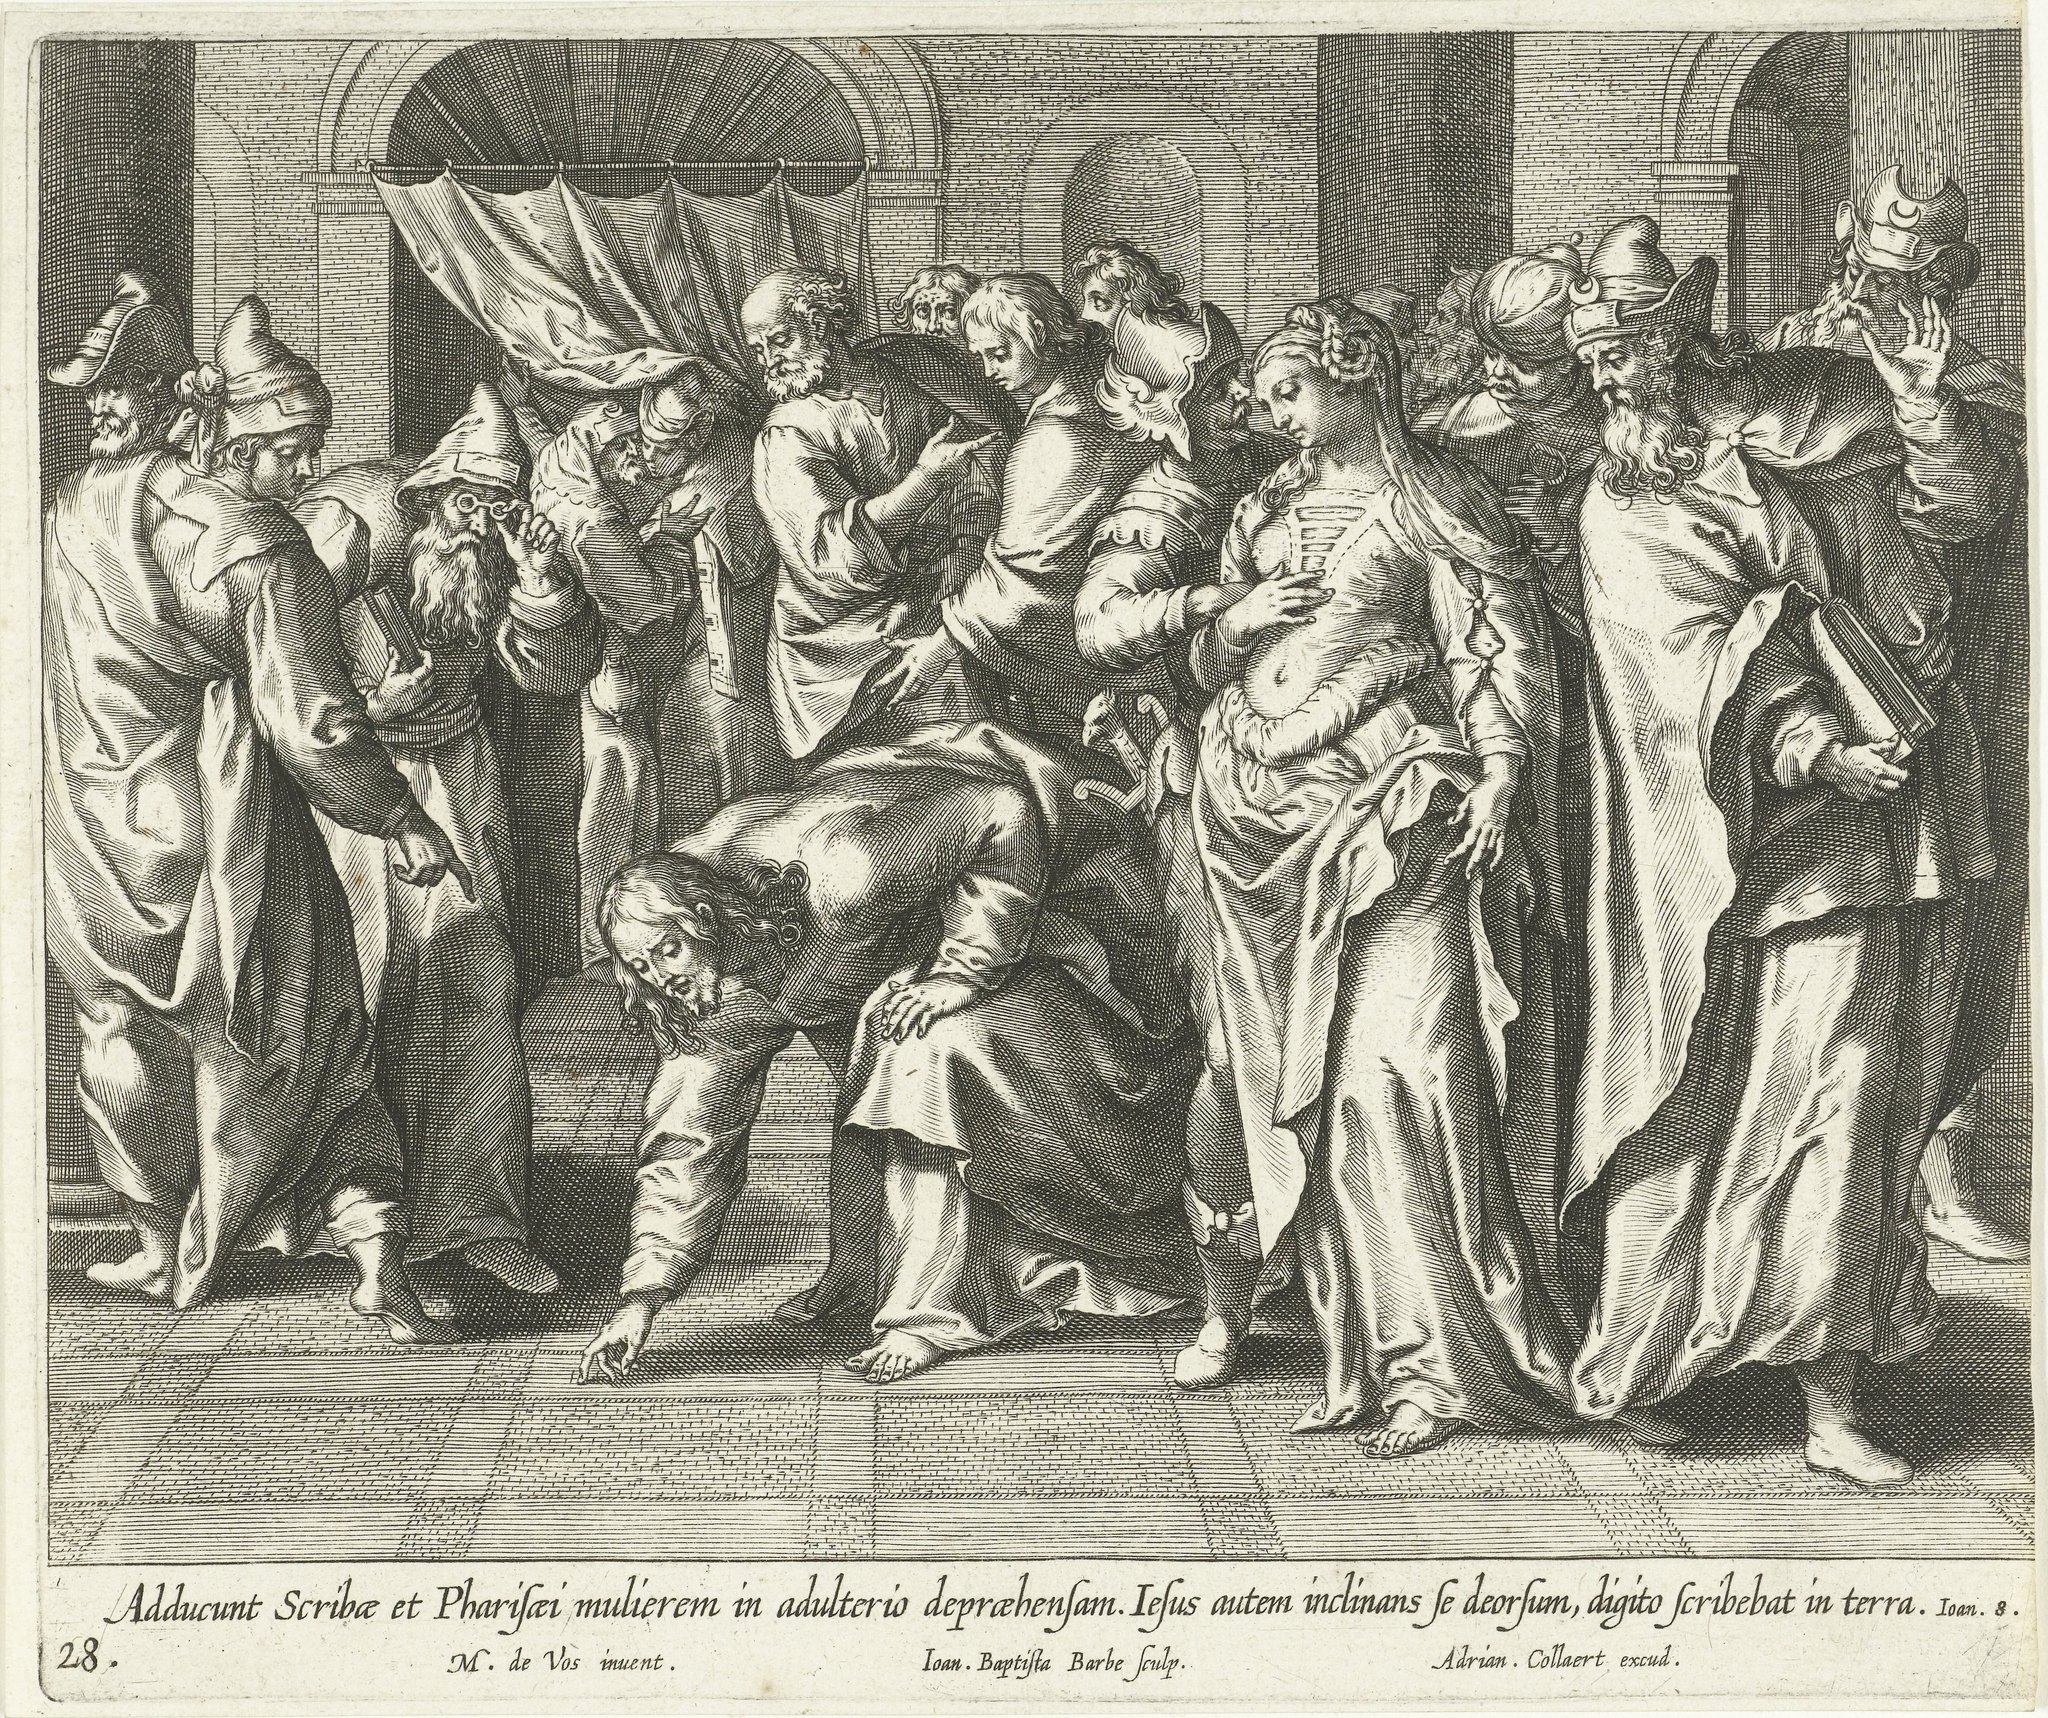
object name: print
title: Christus en de overspelige vrouw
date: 1598-1618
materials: paper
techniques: engraving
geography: antwerp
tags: christ points to or writes on the ground, pharisees bring a woman accused of adultery before christ (john 8:2-11)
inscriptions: collector's mark: Lugt 2228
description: In de tempel van Jeruzalem brengen de Farizeeën een vrouw die betrapt is op overspel naar Christus. Hij moet oordelen over haar. Christus schrijft met zijn vinger in de grond en zegt: "Wie zonder zonde is, werpe de eerste steen" (Johannes 8:2-11). De prent heeft een Latijns onderschrift. De prent maakt deel uit van een serie over het leven van Christus.